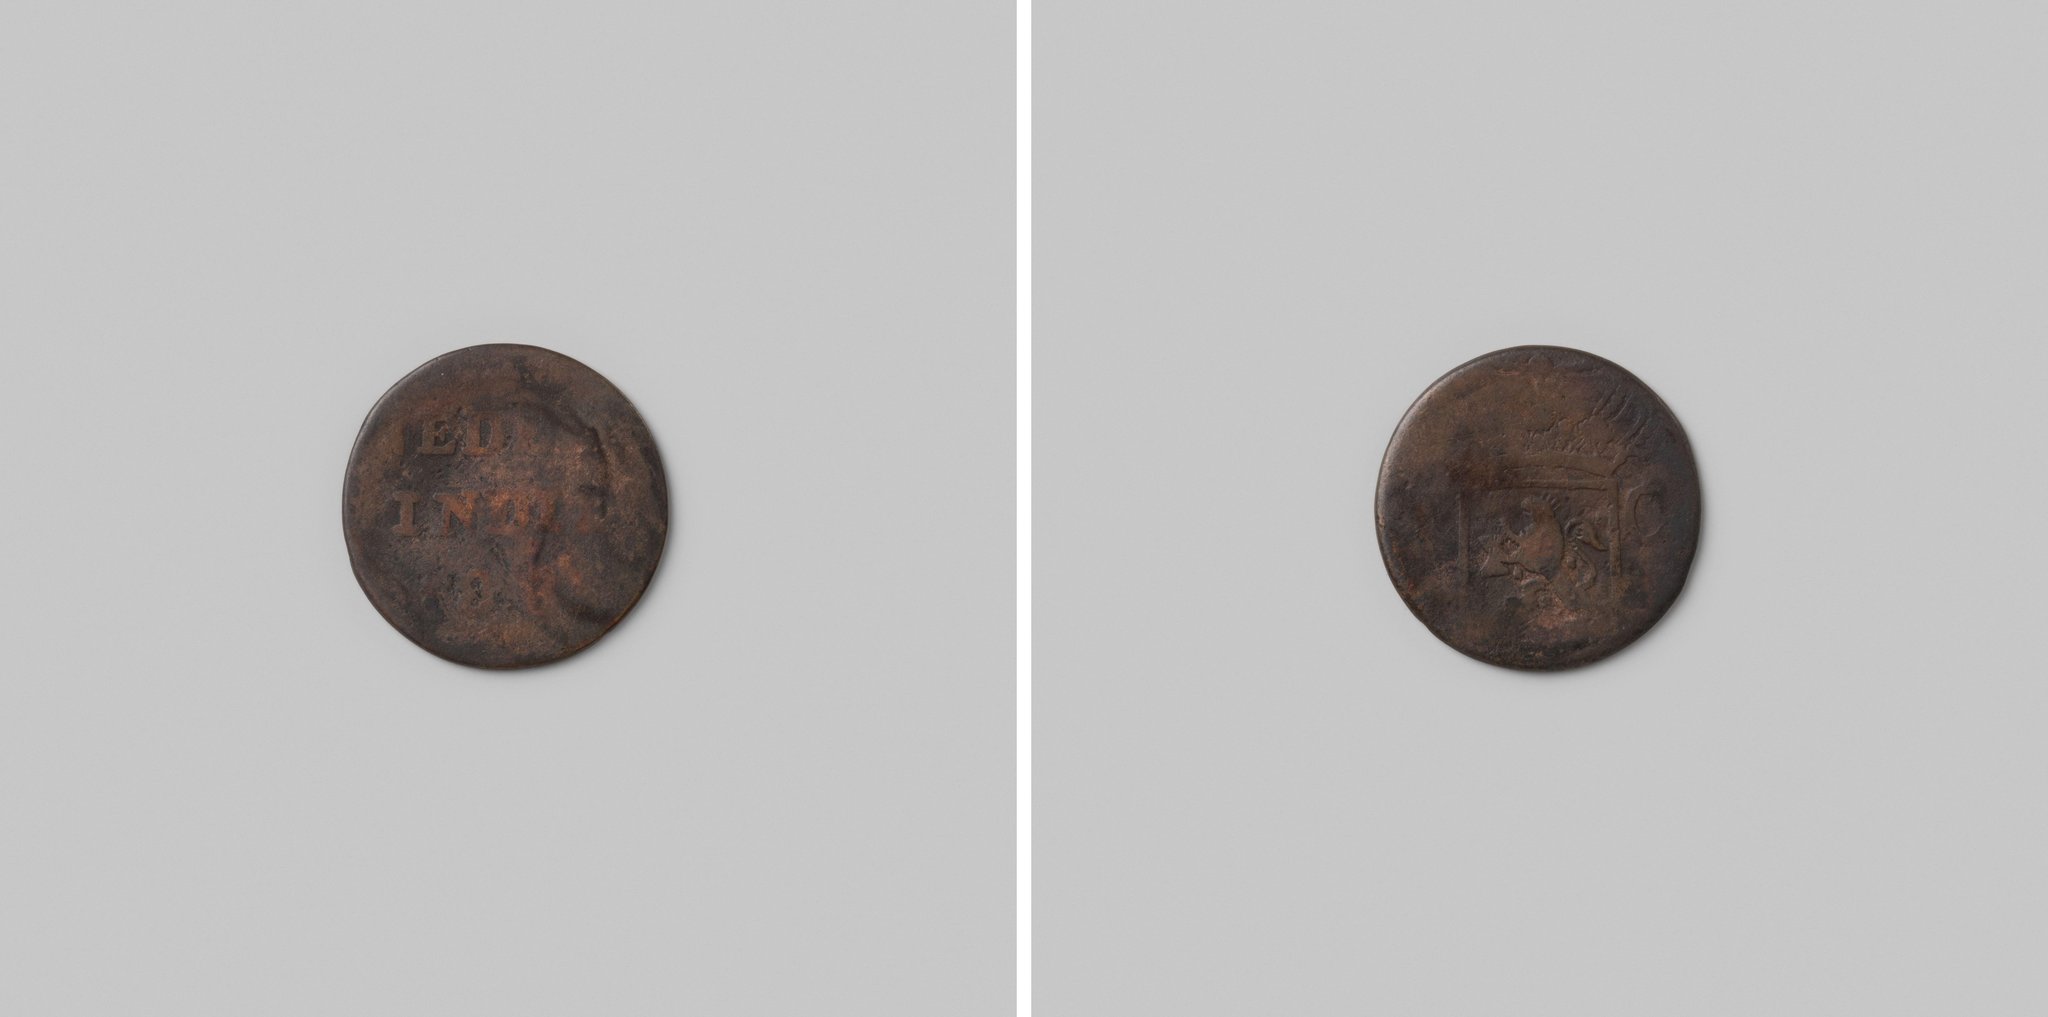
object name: coin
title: Koperen muntje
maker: Anonymous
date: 1700-1900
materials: copper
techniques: striking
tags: oost-indië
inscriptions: inscription: ‘...ED.... / INDI.. / .....’, inscription: ‘Jacques Schulman N.V. / Numismaten / Keizersgracht 448 / Amsterdam-C.’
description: Koperen muntje. Voorzijde: opschrift. Keerzijde: vervaagd wapen met een leeuw erin en recht hiervan de letter C. Het muntje zit in een vierkant envelopje met opschrift.